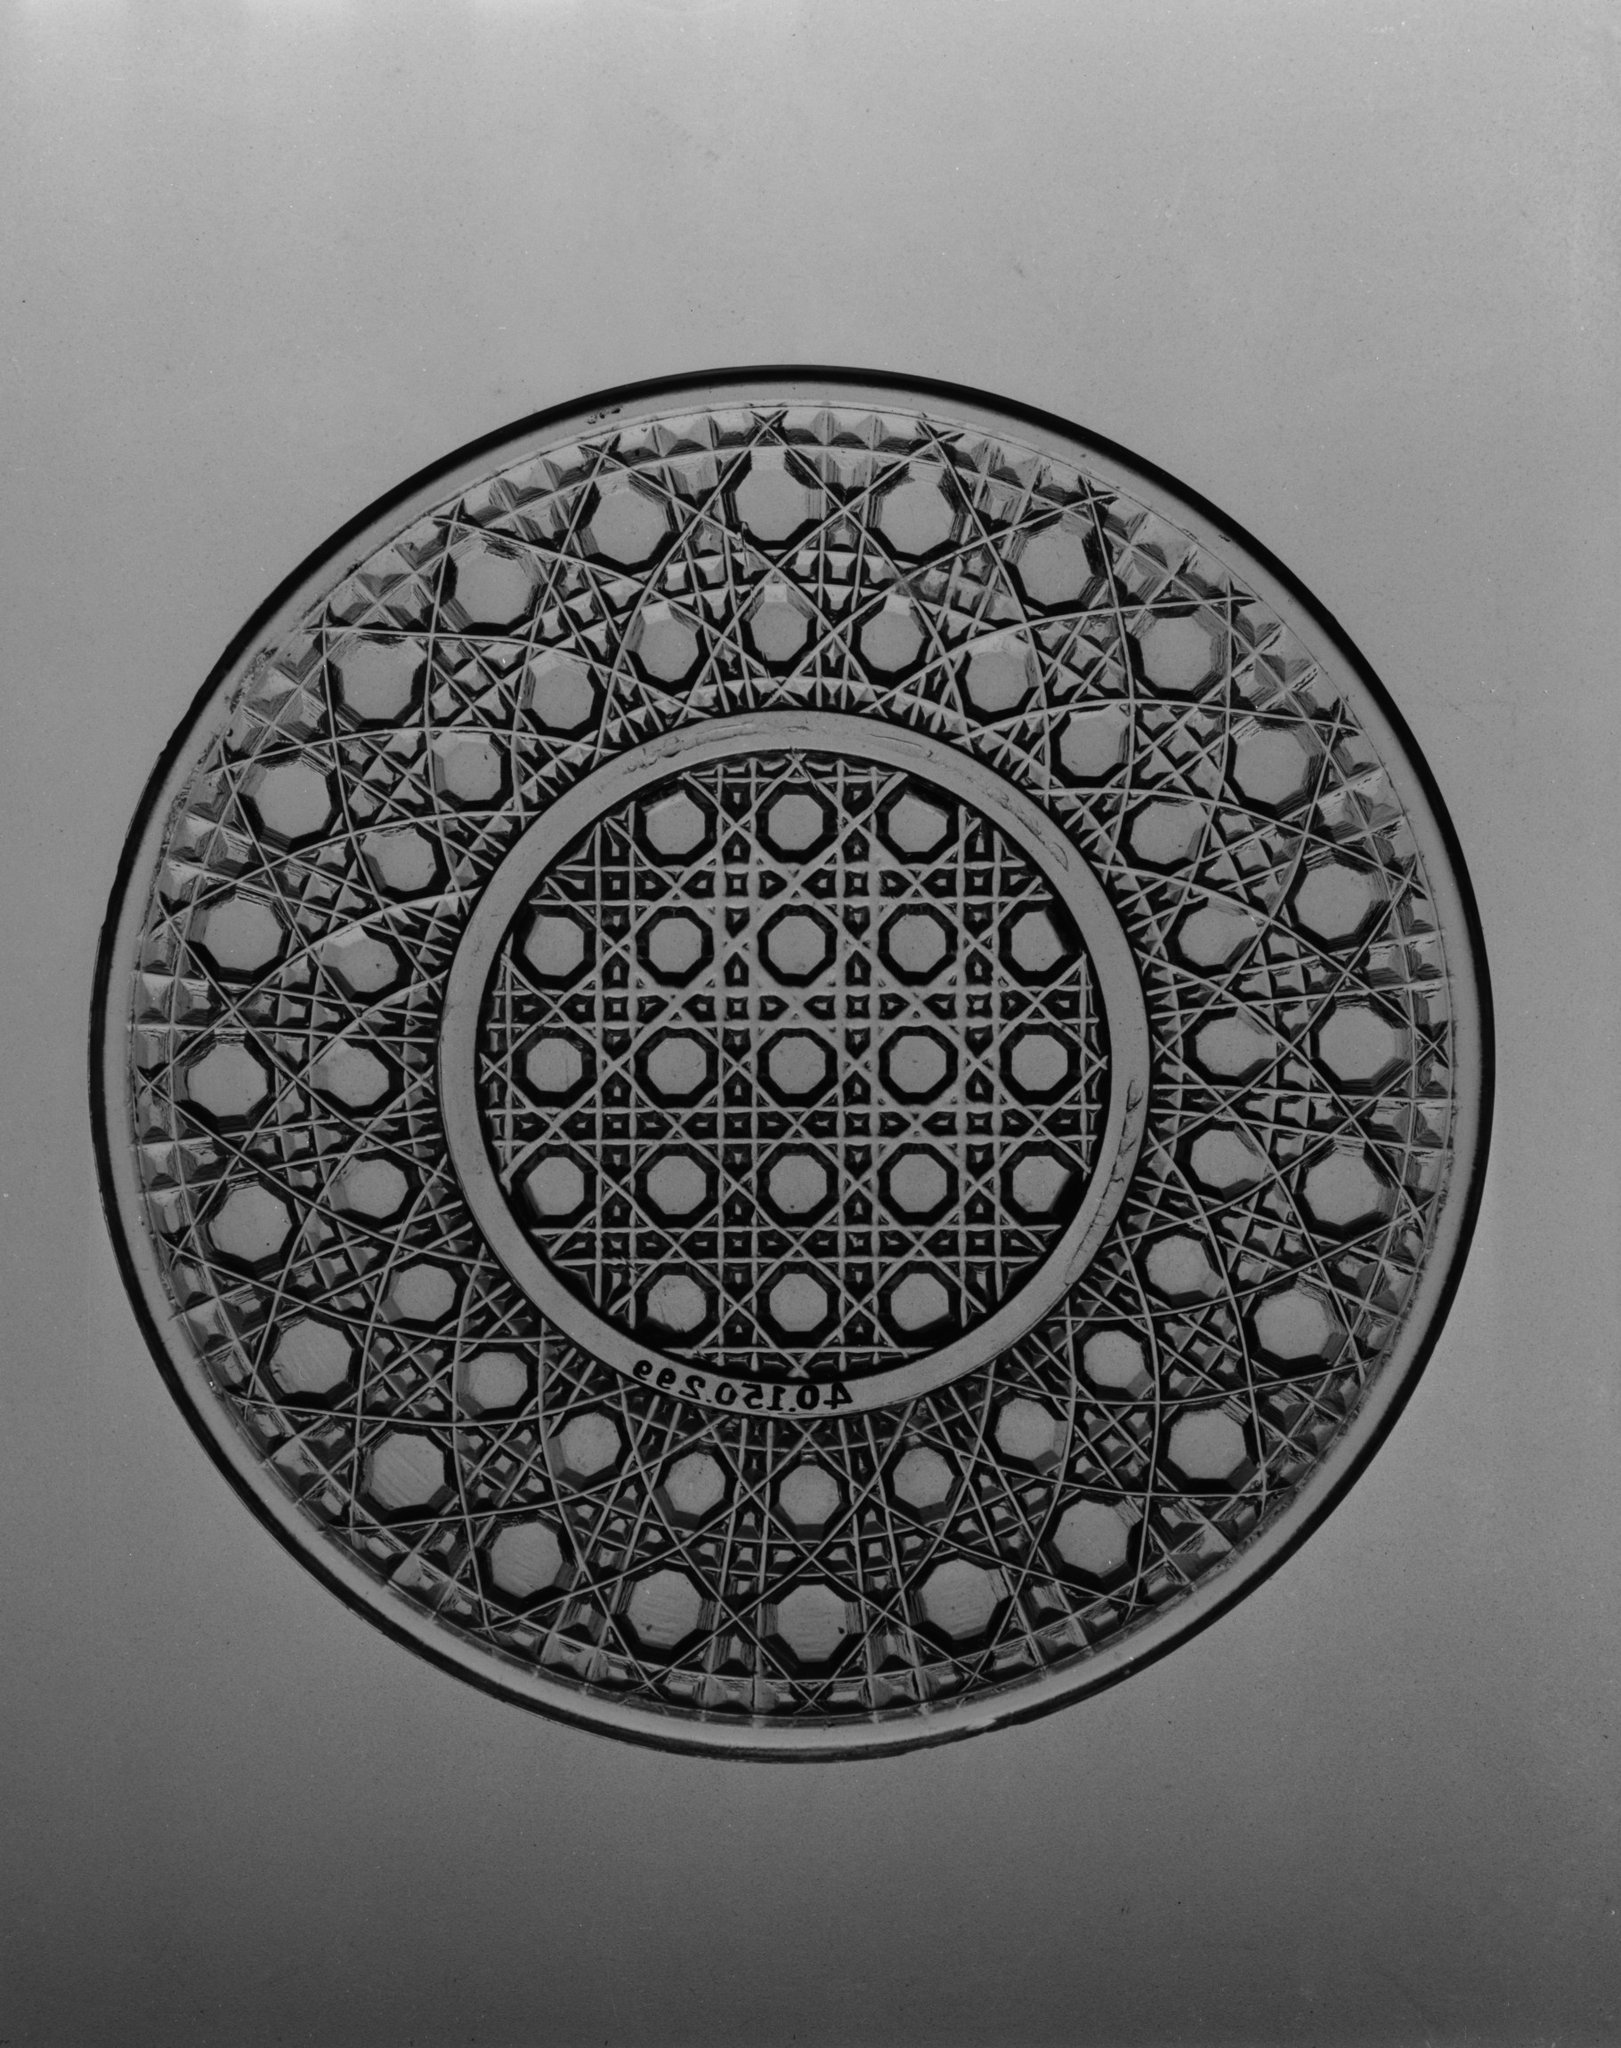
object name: cup plate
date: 1870-1880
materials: glass